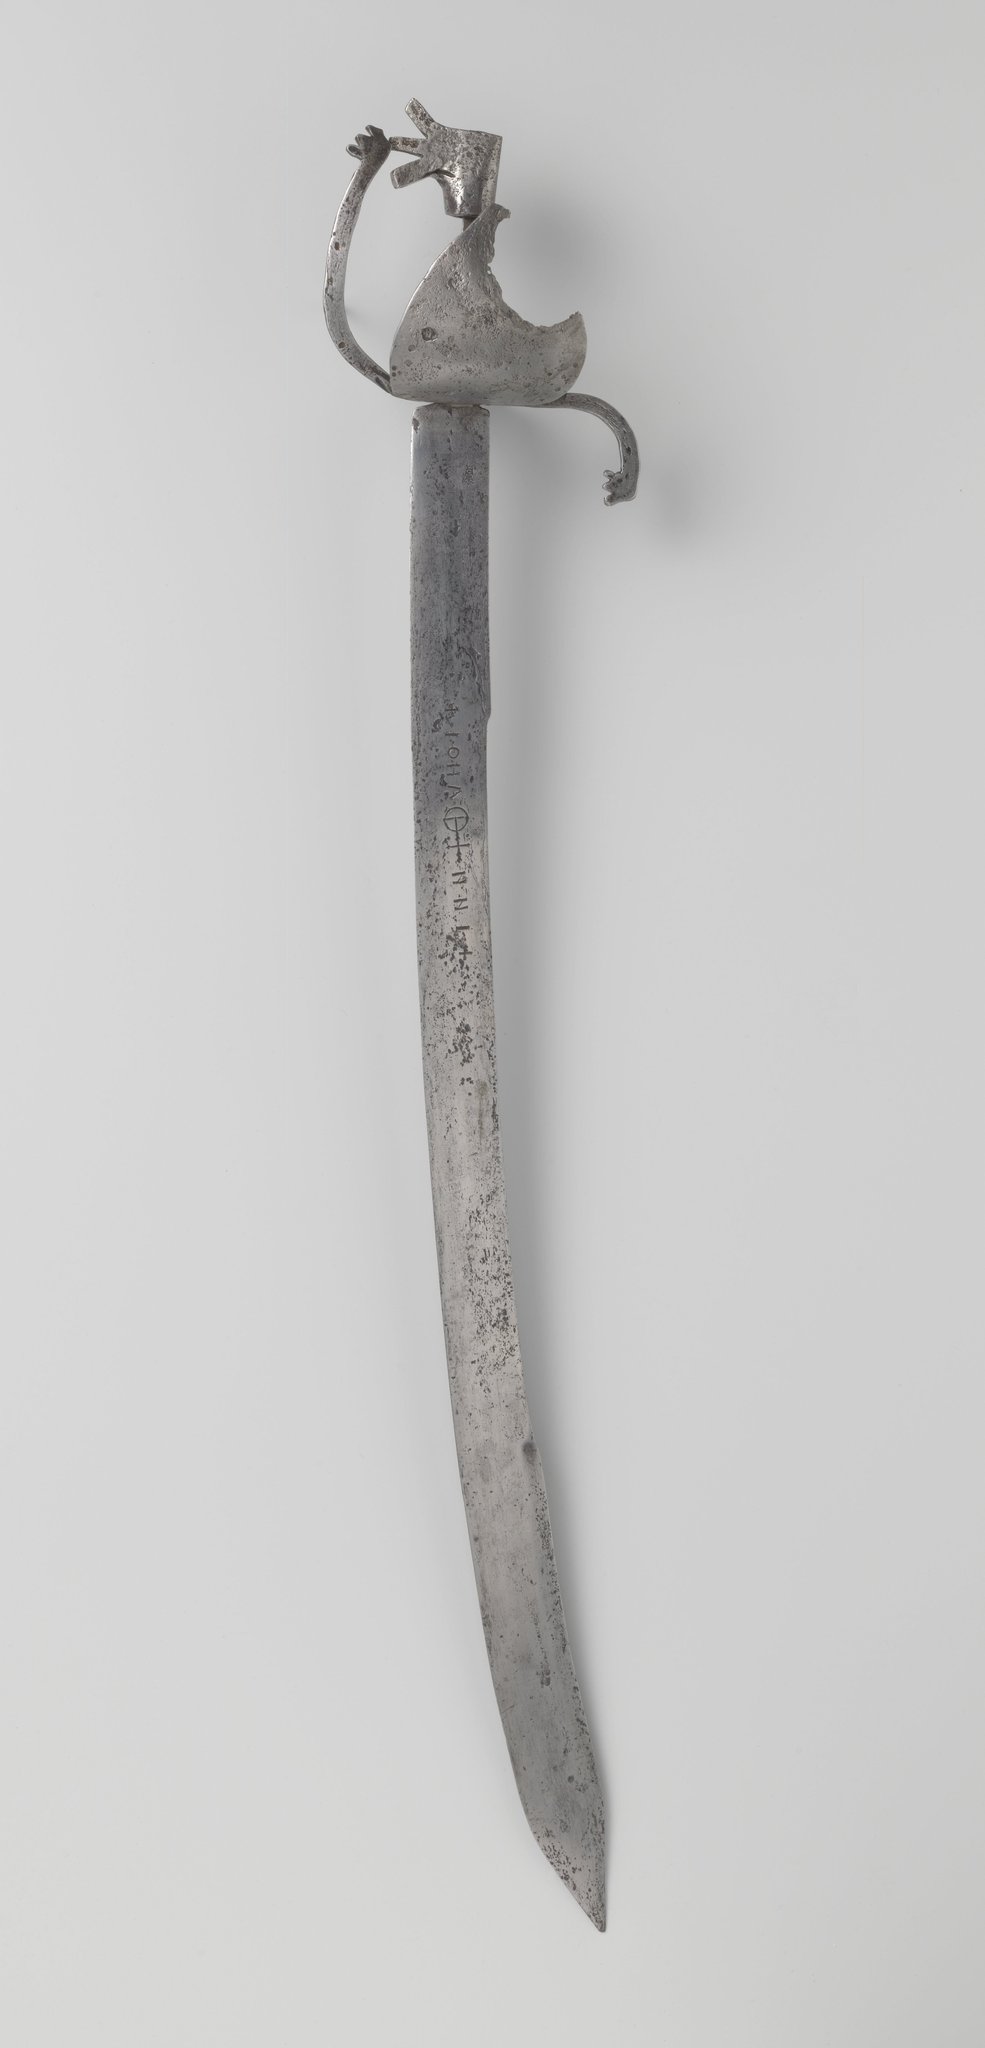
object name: sinclair sword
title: Sinclairsabel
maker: Anonymous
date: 1600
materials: iron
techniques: etching, forging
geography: solingen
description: Sabre, made in Solingen, c. 1600.